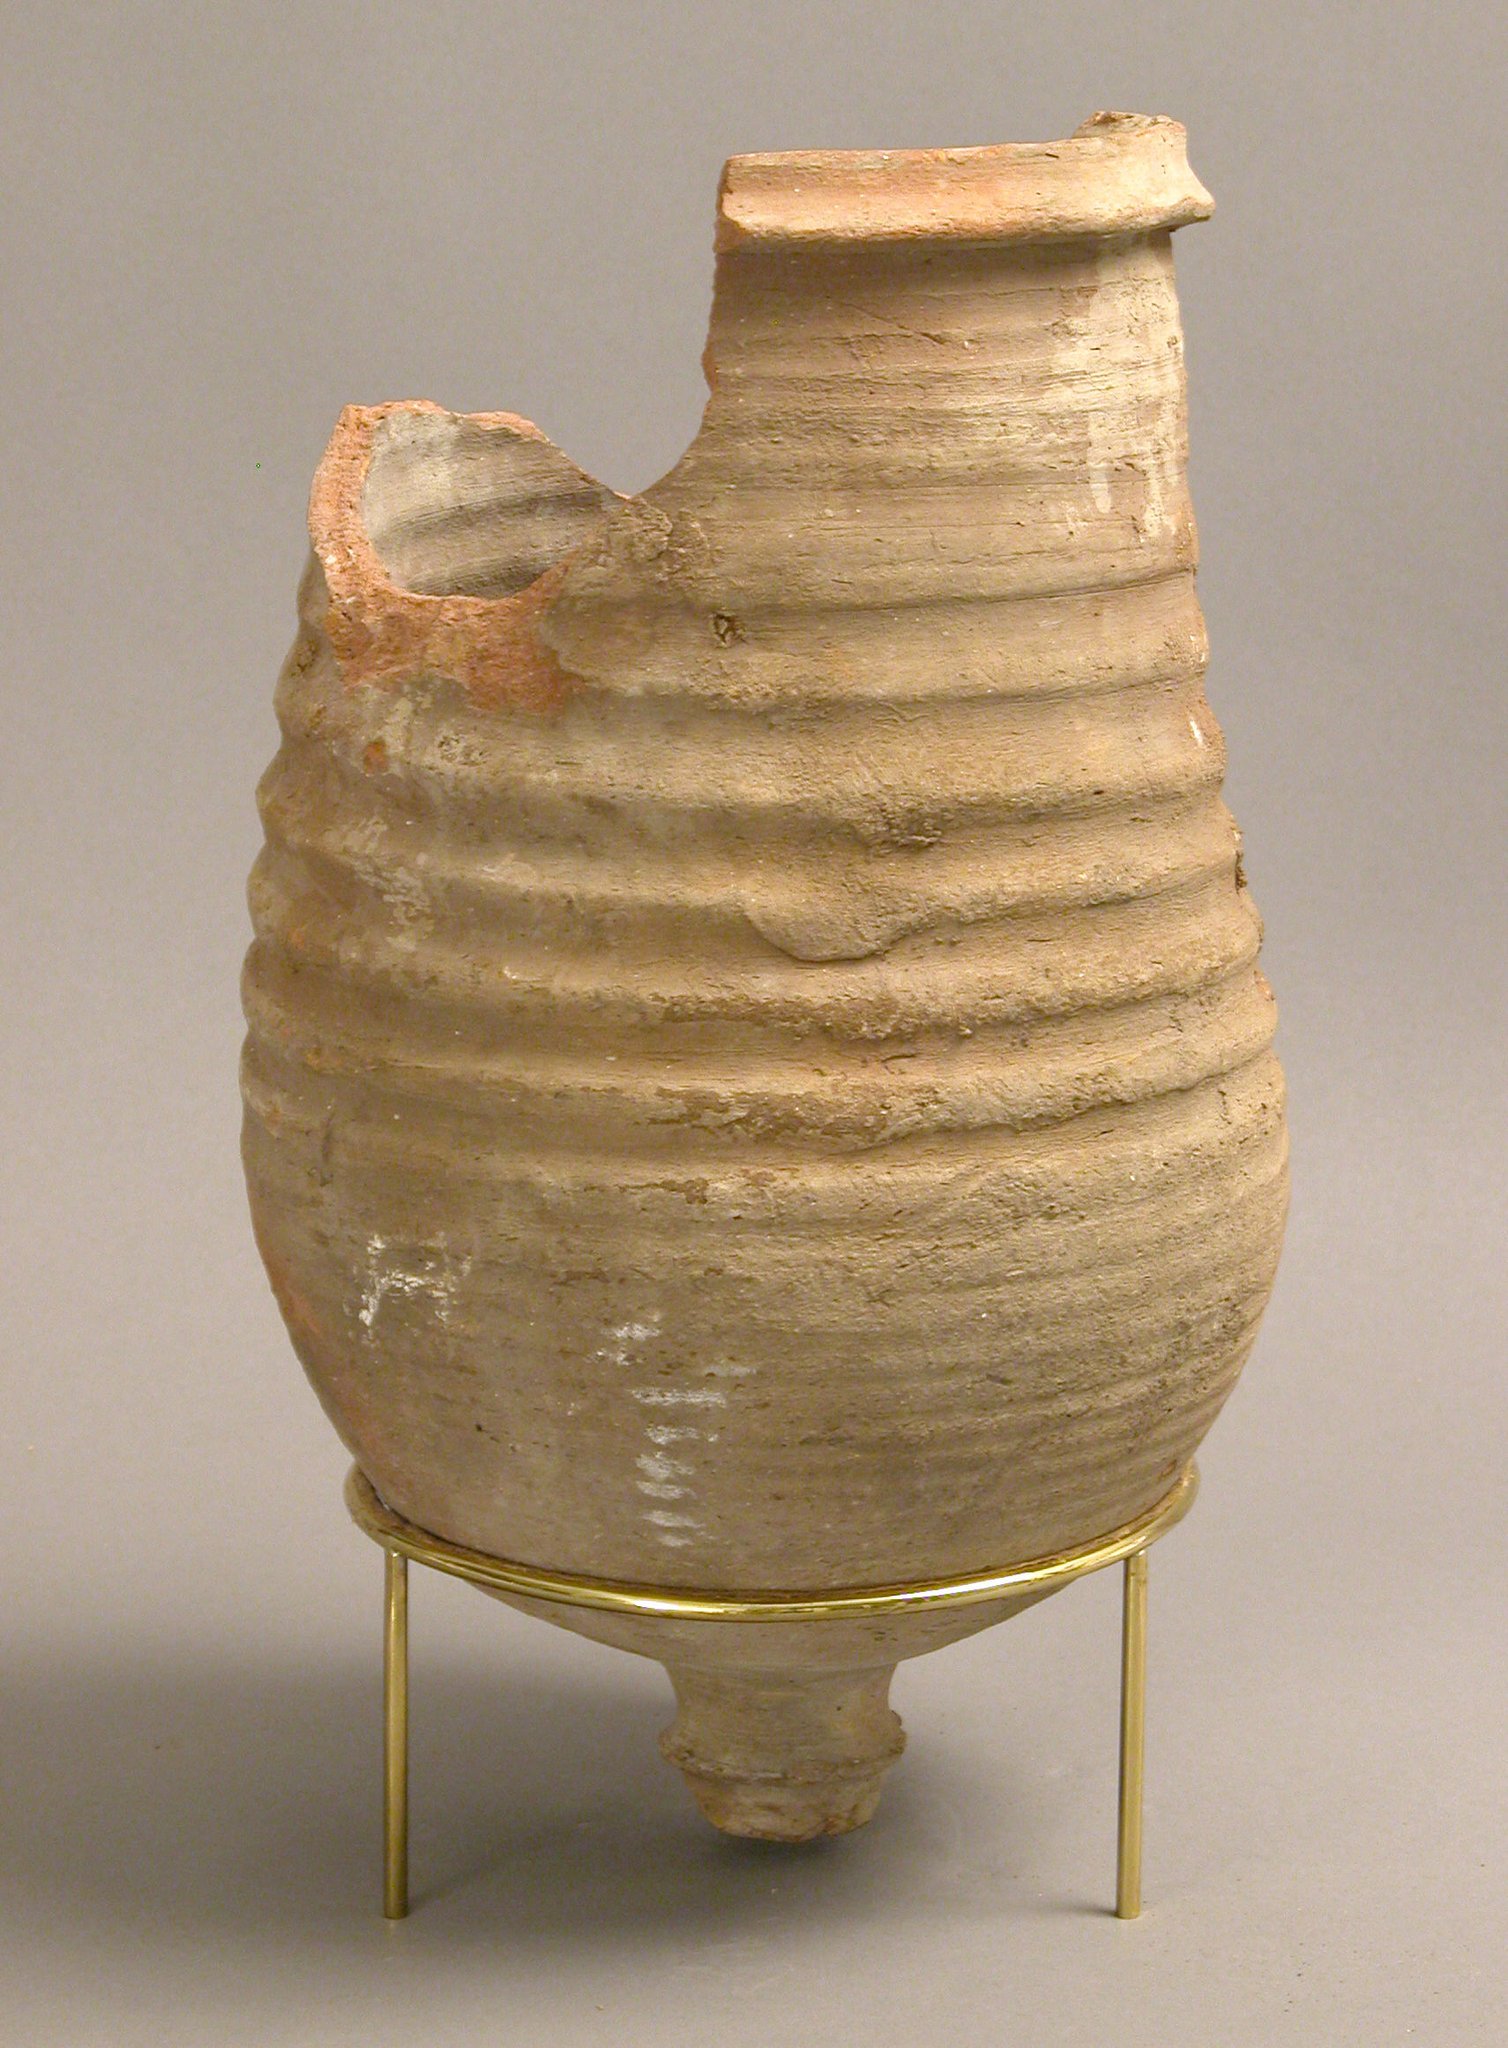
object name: bucket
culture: coptic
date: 301-700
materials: earthenware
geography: egypt